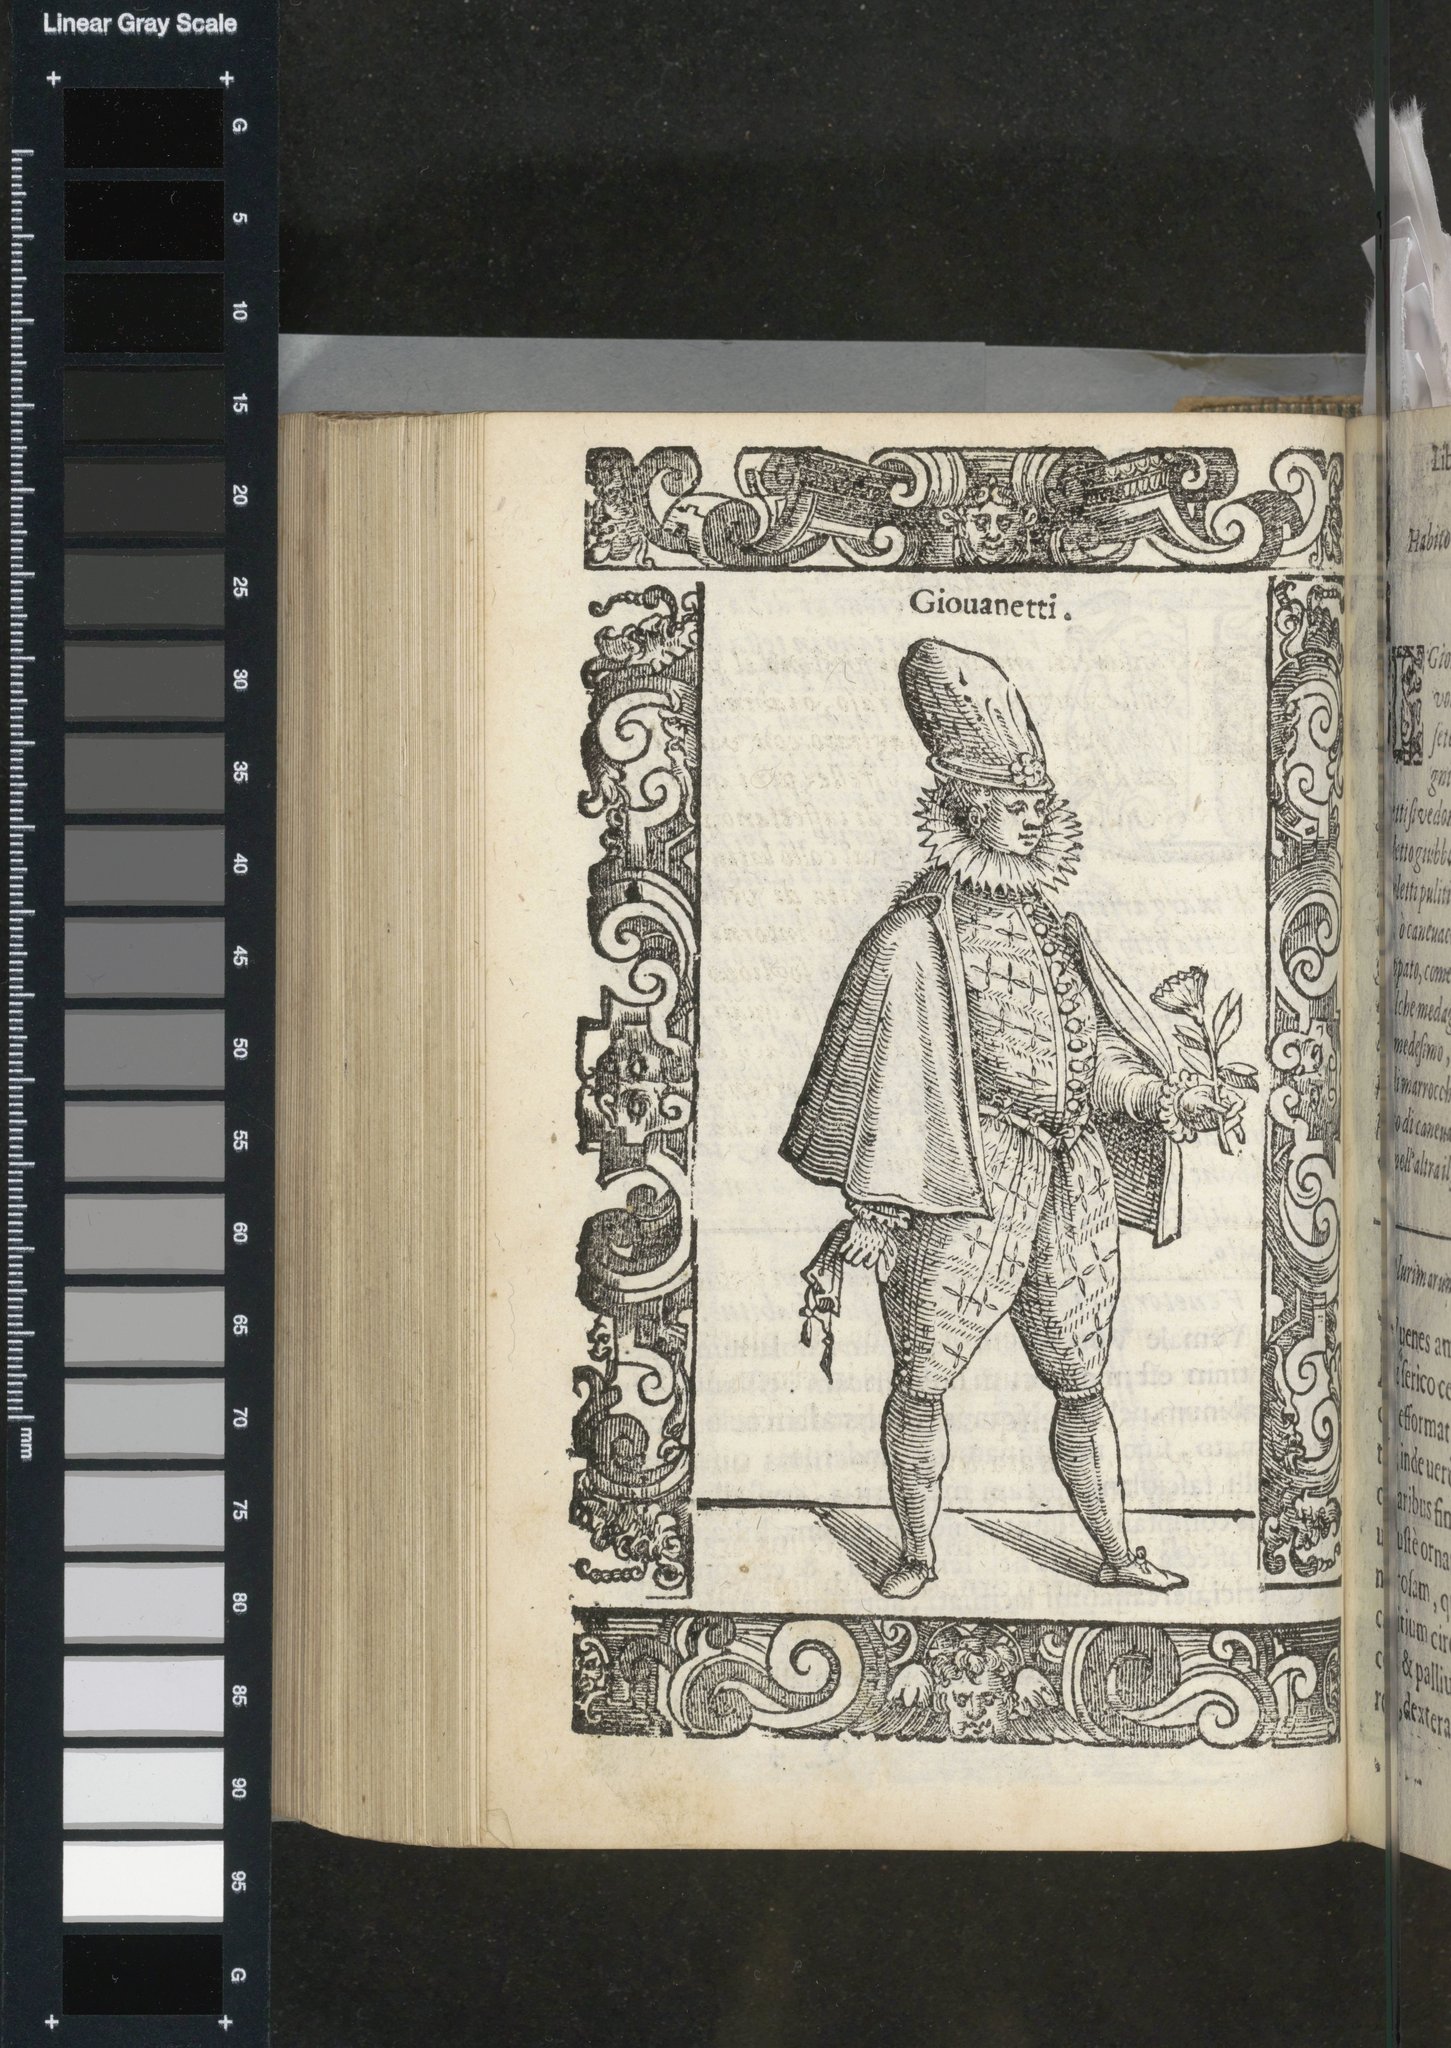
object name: costume print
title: Habiti antichi, et moderni di tutto il mondo...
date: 1598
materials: paper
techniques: woodcut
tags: fashion plates